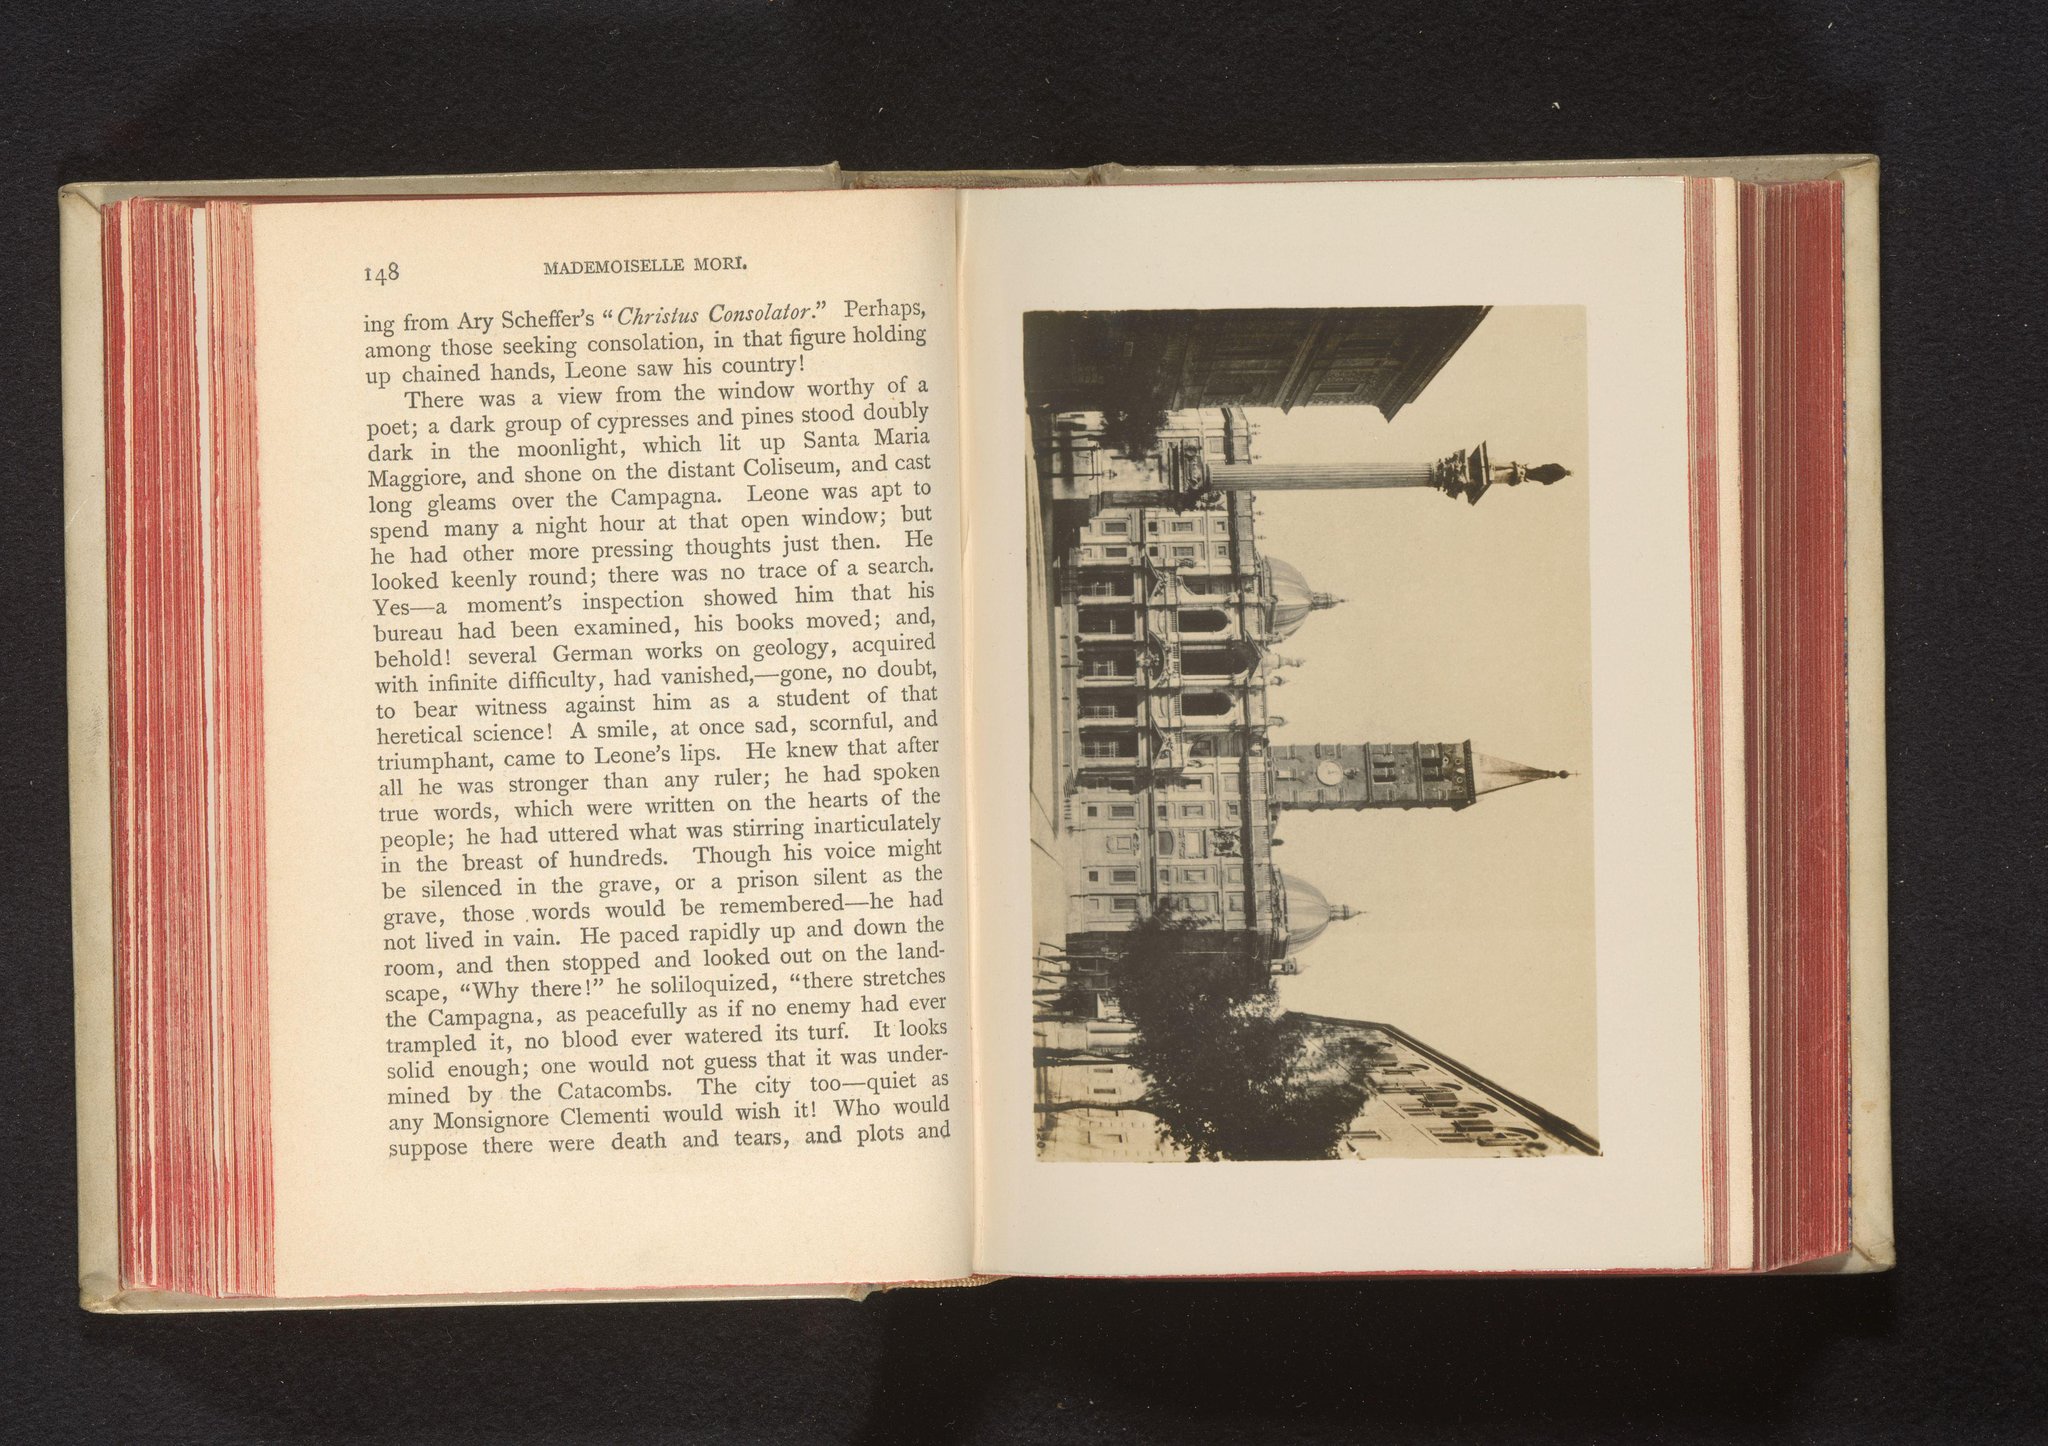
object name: photograph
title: Voorgevel van de Basiliek van Santa Maria Maggiore te Rome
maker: Anonymous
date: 1852-1862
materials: photographic support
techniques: gelatin silver print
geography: rome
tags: square, place, circus, etc., church (exterior), façade (of house or building)